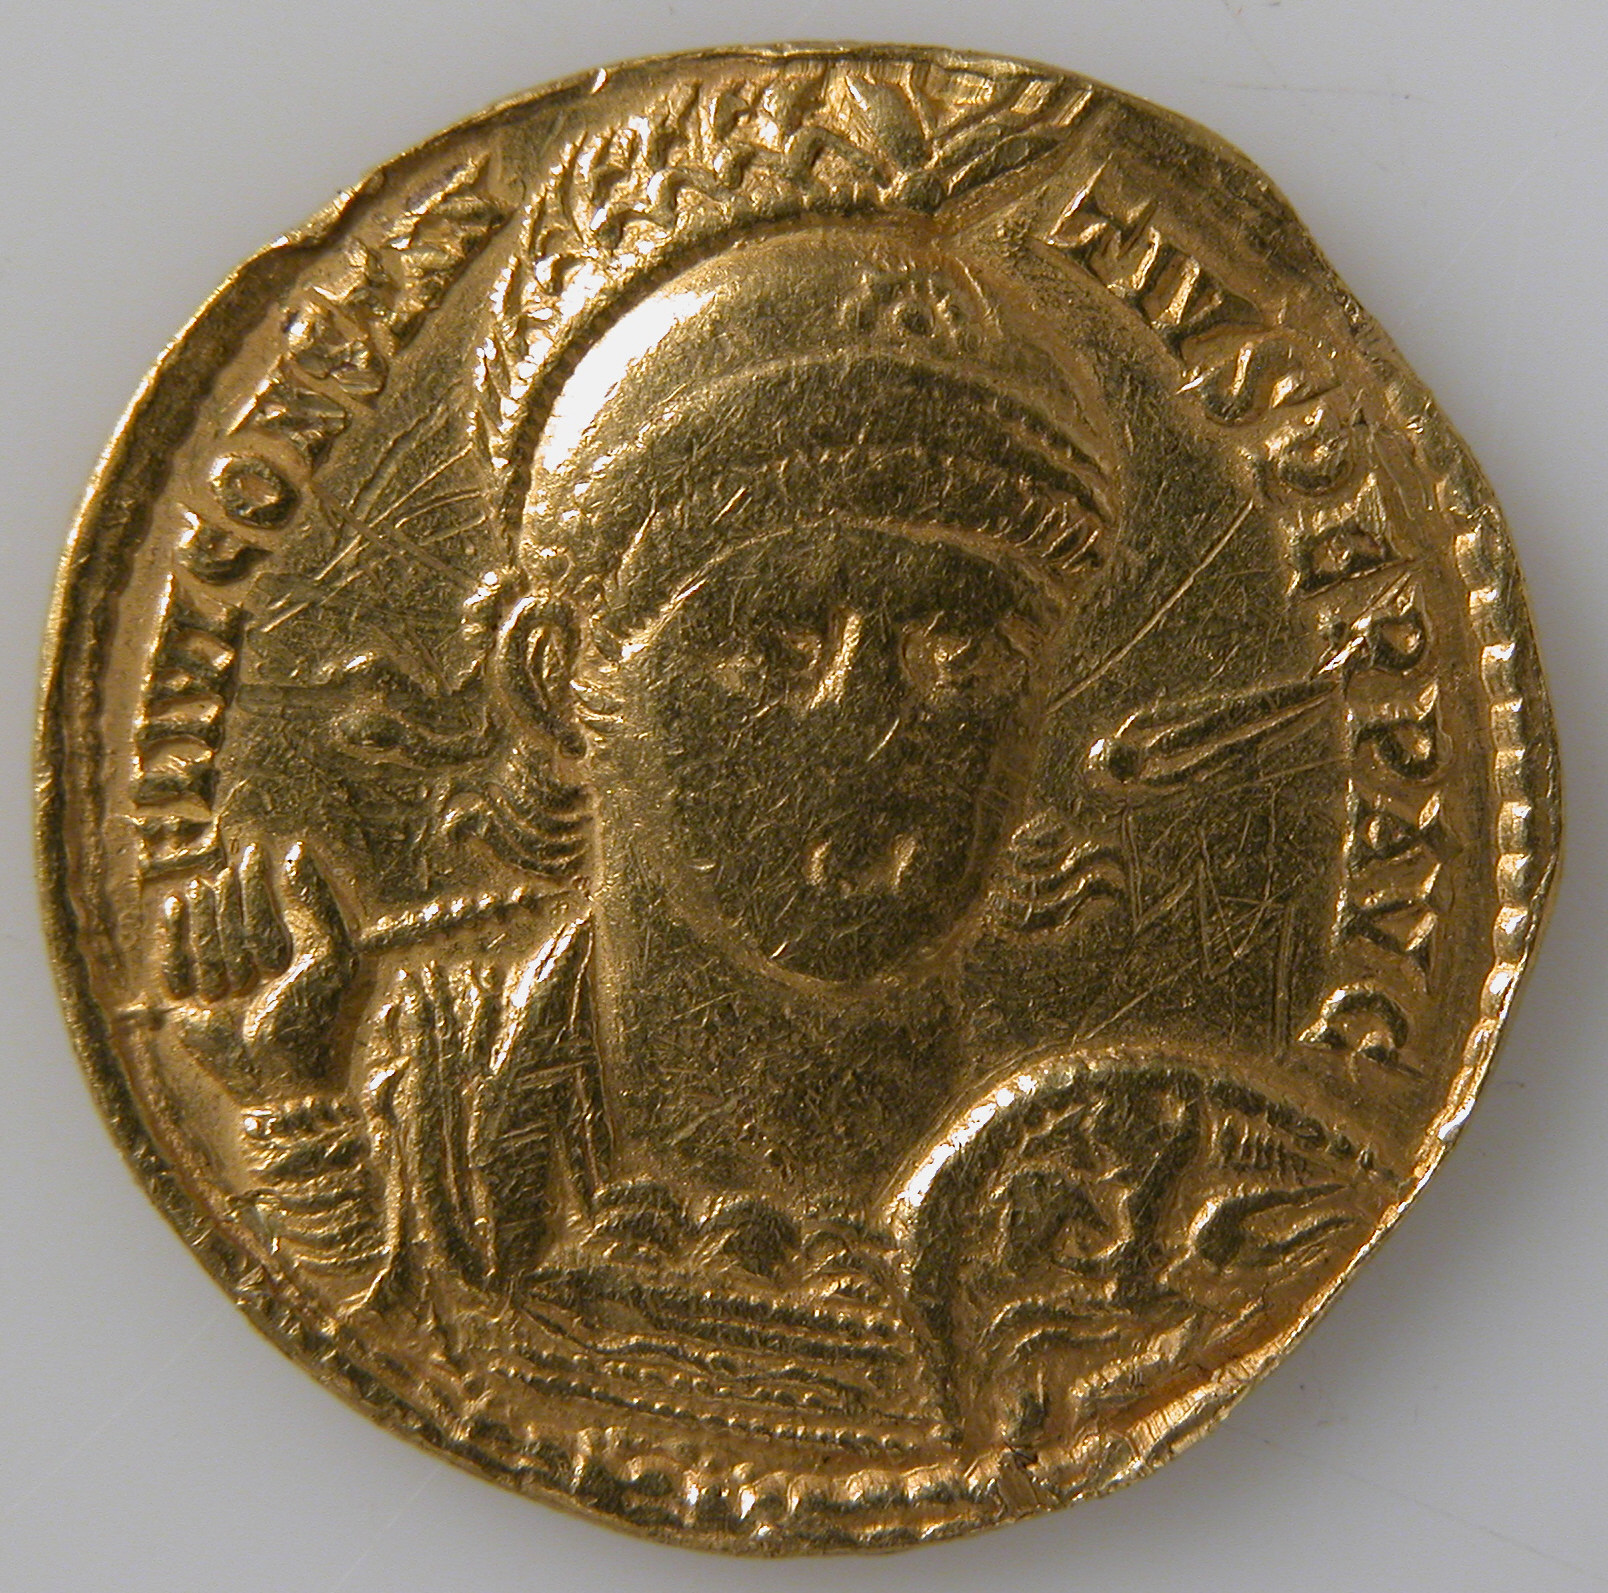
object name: solidus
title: Solidus of Constantius II (Sole Emperor, 353–361)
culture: byzantine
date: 353-361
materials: gold